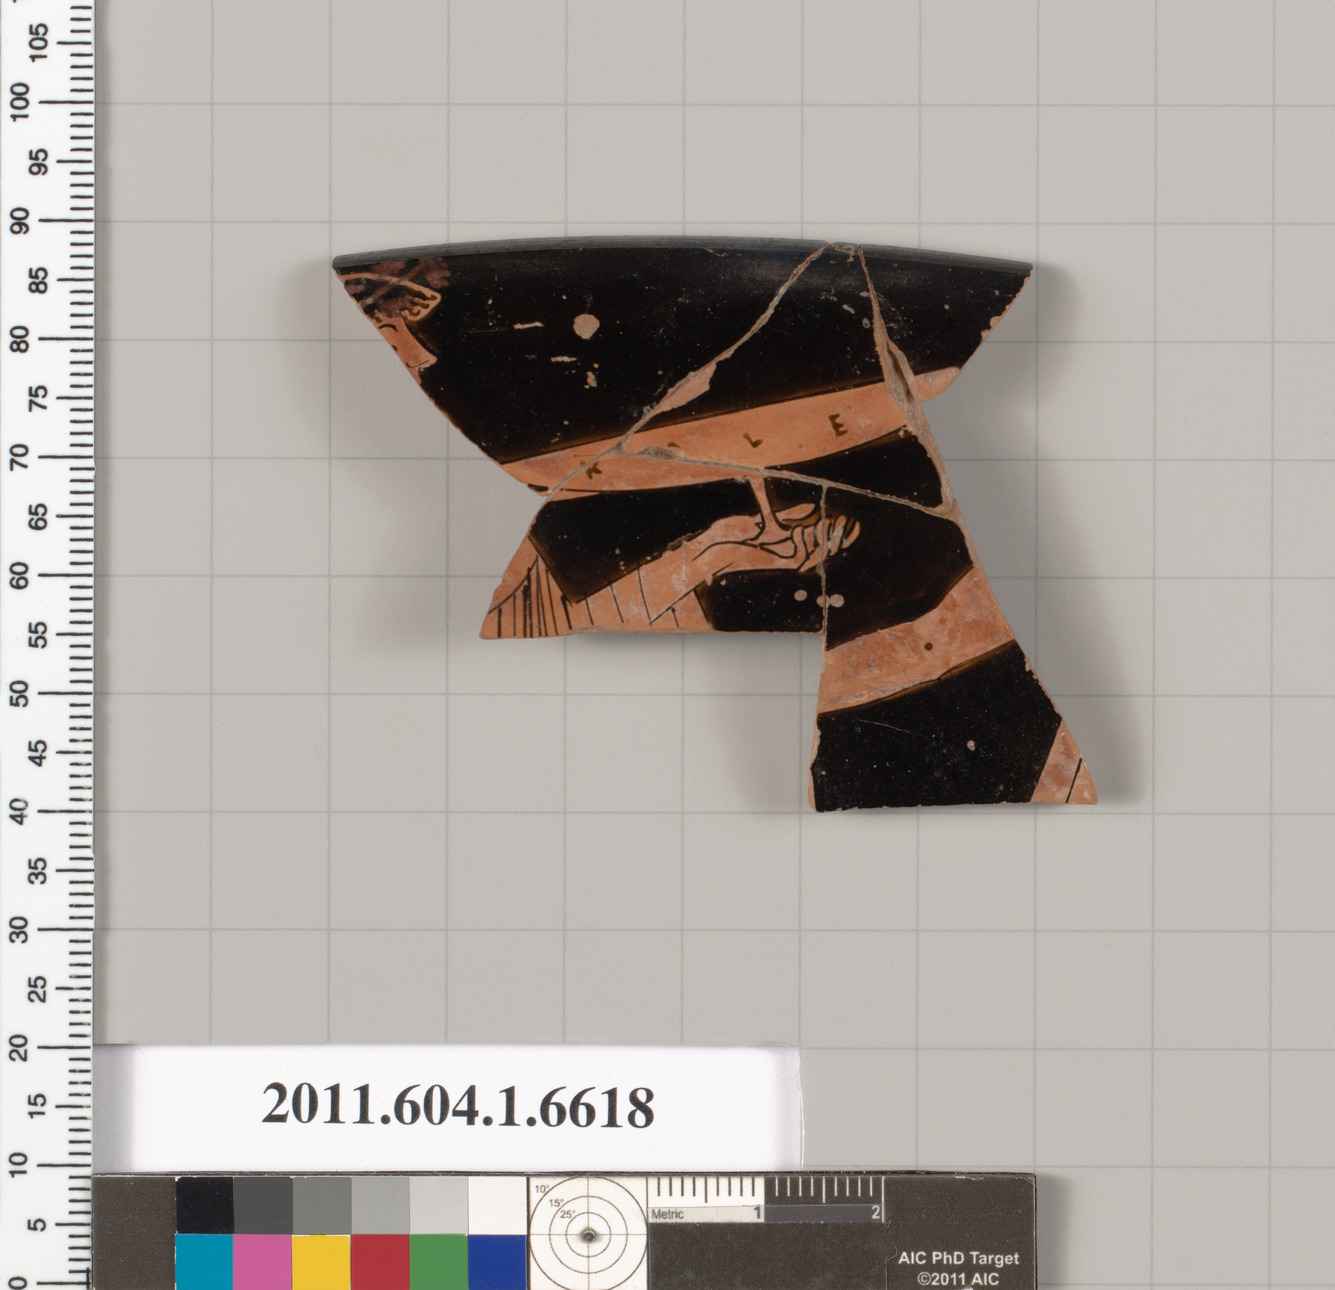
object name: kylix fragment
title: Terracotta rim fragment of a kylix (drinking cup)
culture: greek, attic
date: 490-470 BCE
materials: terracotta